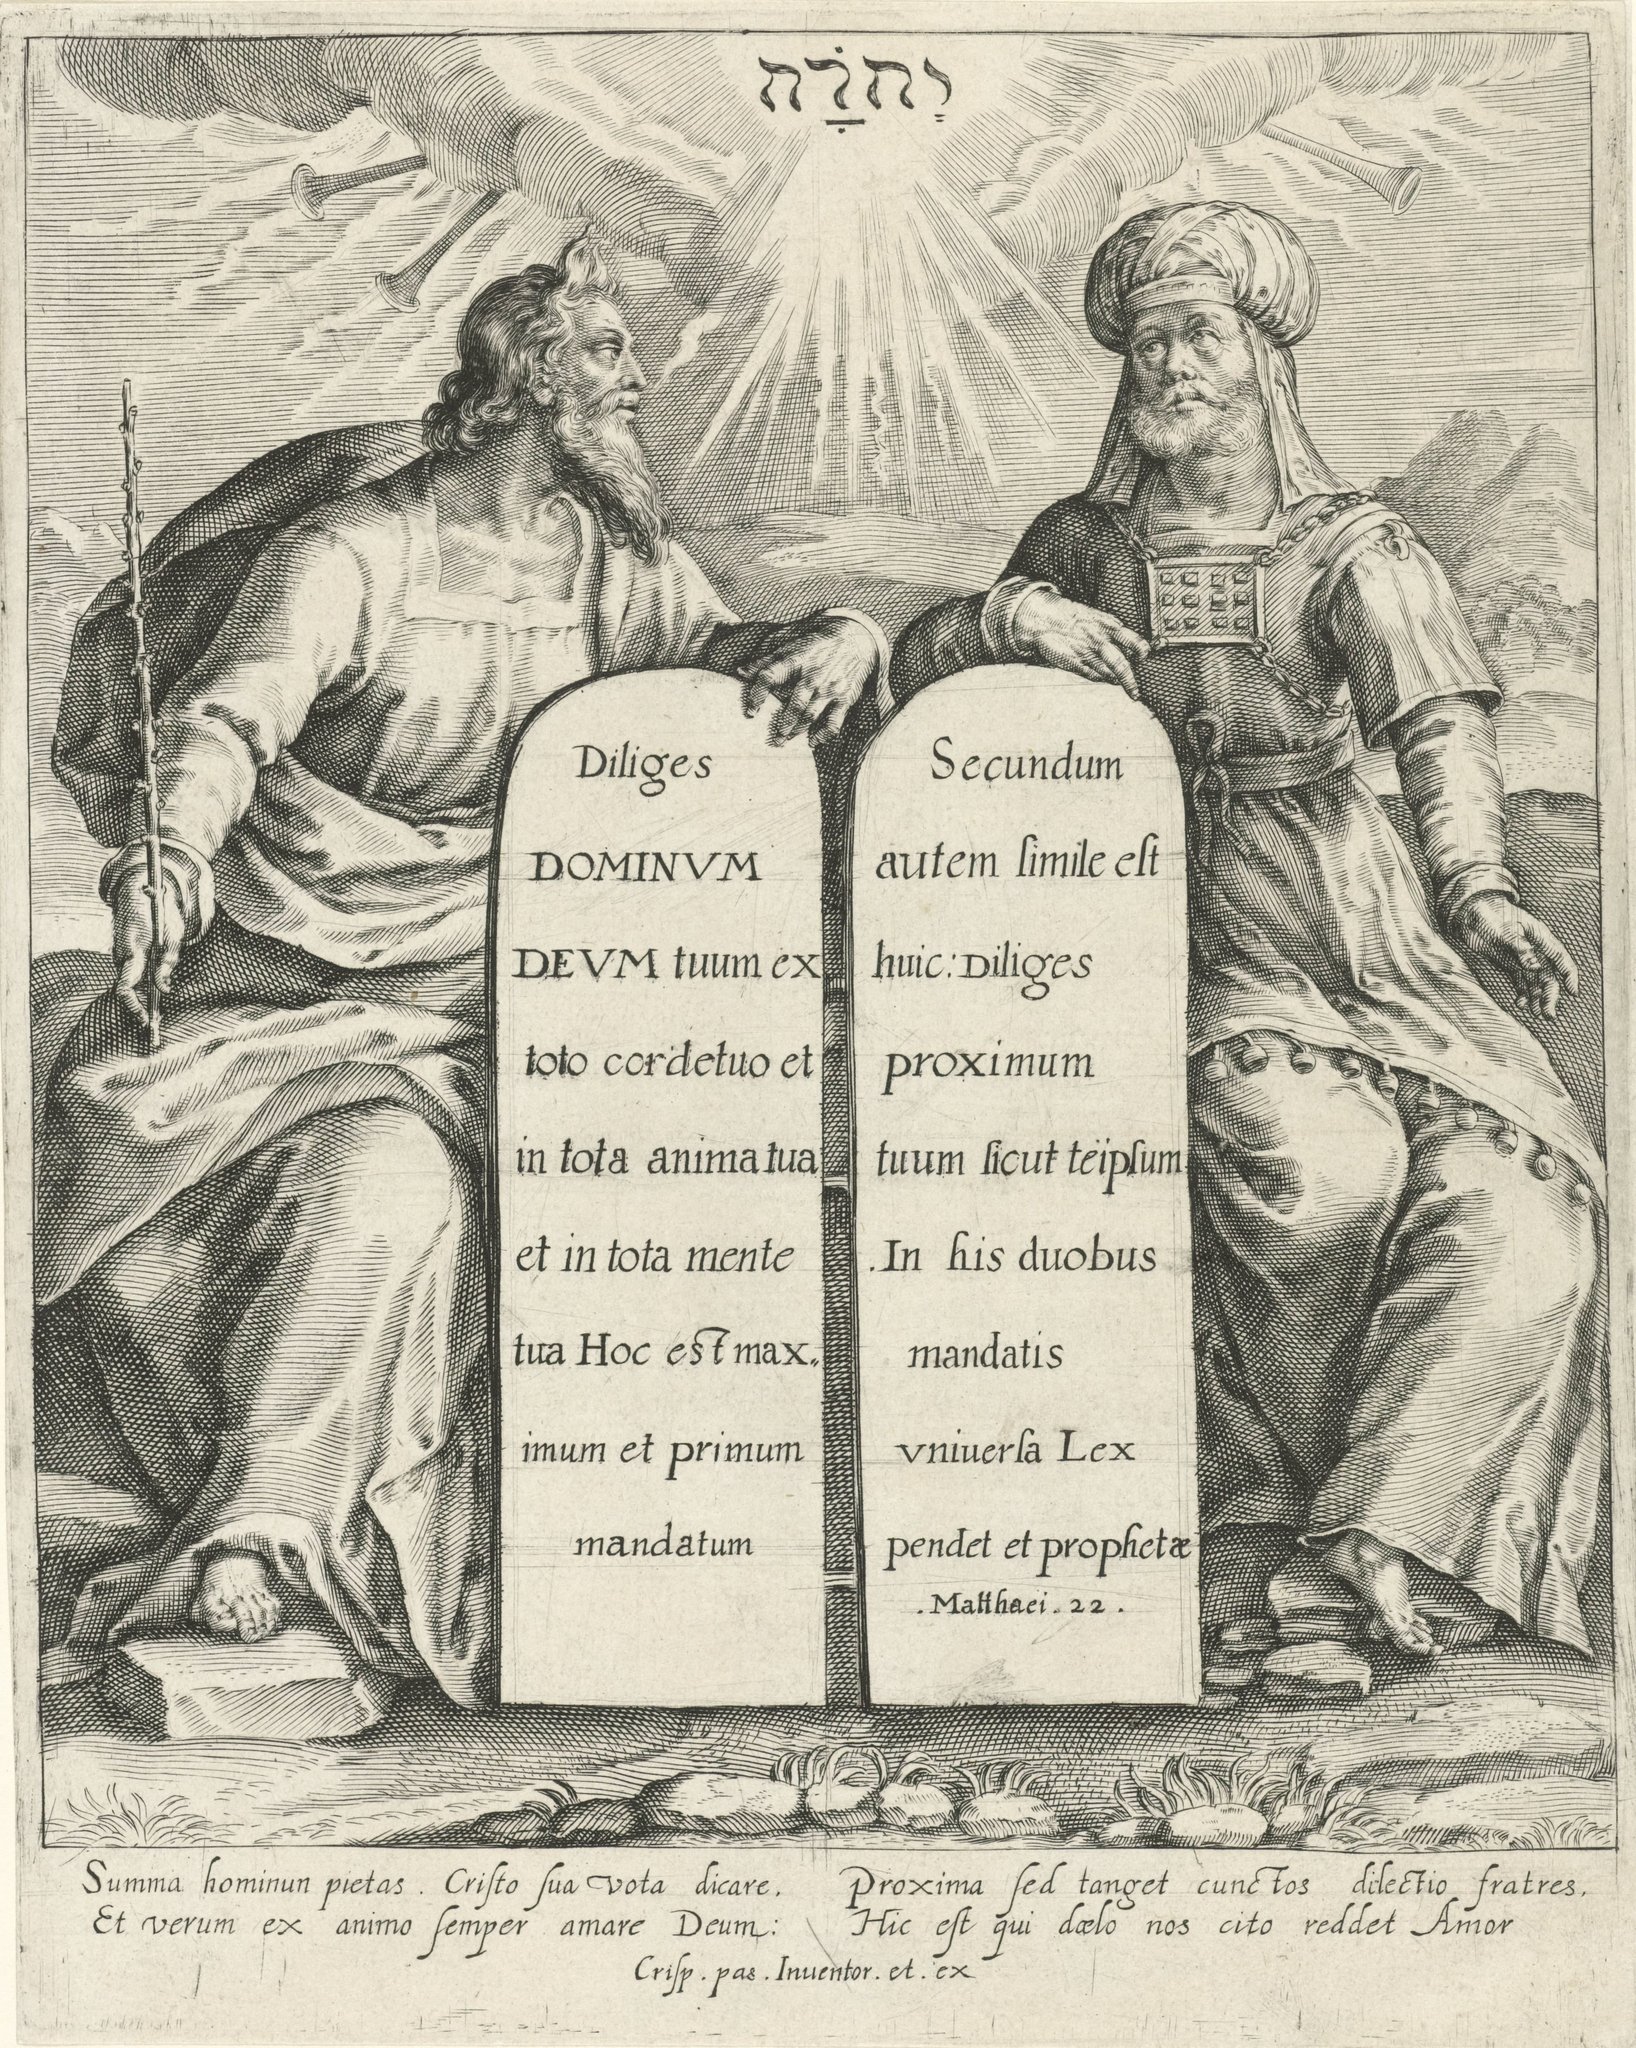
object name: print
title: Mozes en Aäron met de tafelen der wet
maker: crispijn van de passe (i)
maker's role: draughtsman, print maker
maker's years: 1564-1637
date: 1574-1637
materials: paper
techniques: engraving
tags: aaron (not in biblical context); possible attributes: attributes of aaron: censer, dressed as high priest or bishop, ointment jar, rod or flowering wand, tetragram (in roman or hebrew script) ~ symbol of god the father, moses on mount sinai with the tables of the law (exodus 24:9-18, 31:18)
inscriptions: collector's mark: Lugt 2228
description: Landschap met Mozes en Aäron die leunen op de tafelen der wet met tekst in het Latijn. Boven in de lucht het tetragram en bazuinen. In de marge een tweeregelig onderschrift in het Latijn.